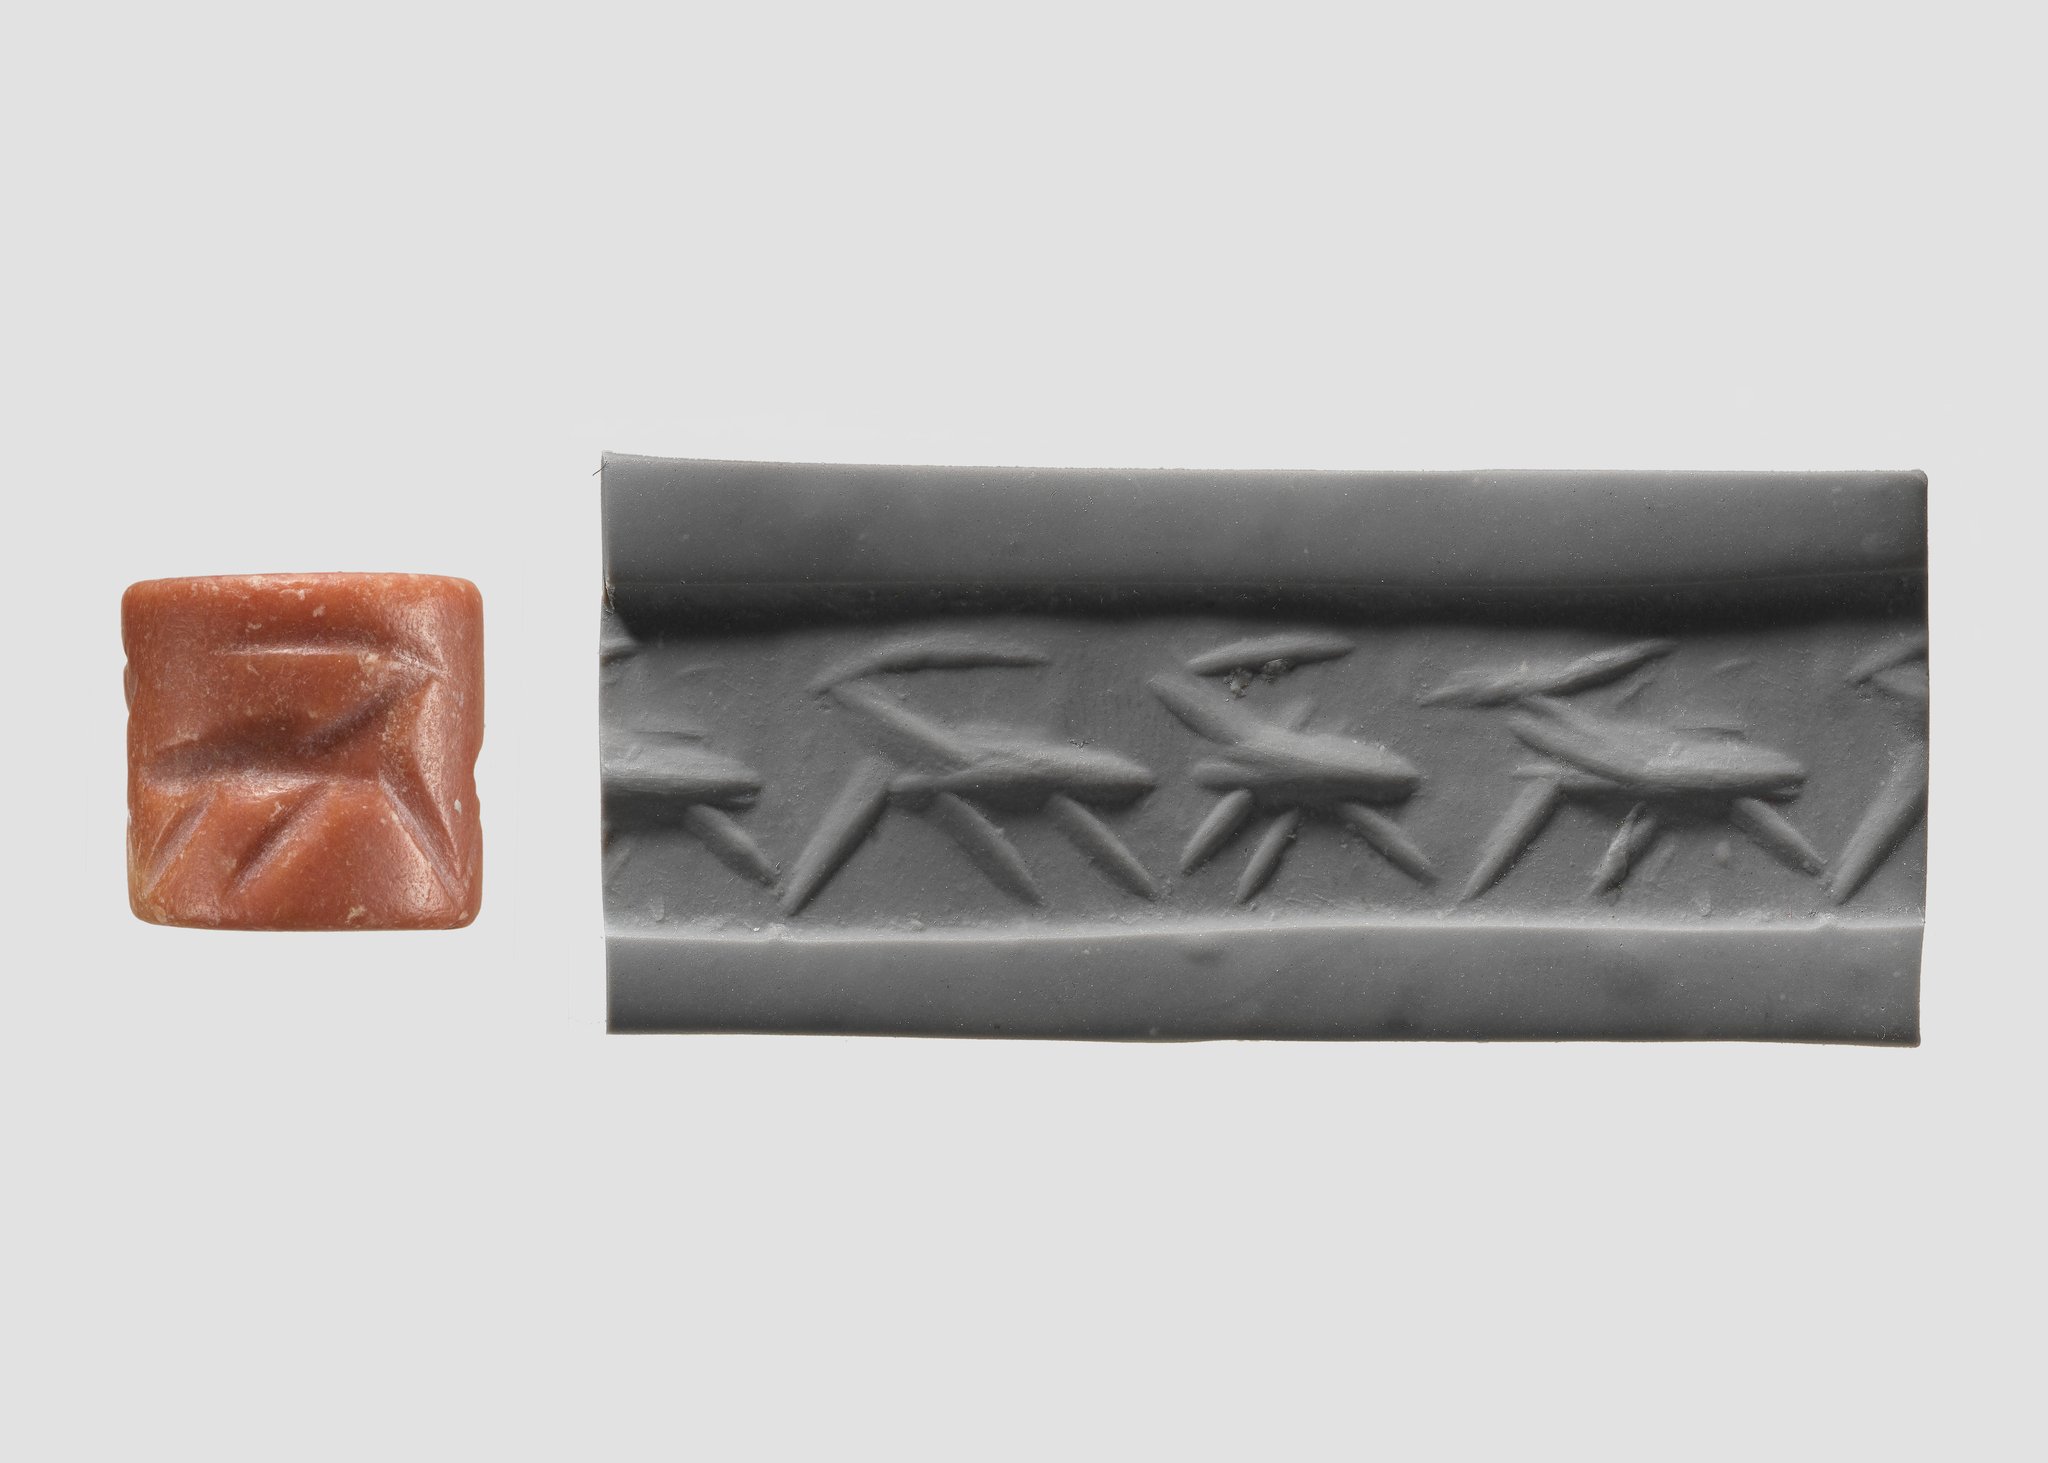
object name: cylinder seal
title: Cylinder seal with horned animals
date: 3100-2900 BCE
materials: marble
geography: mesopotamia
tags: animals